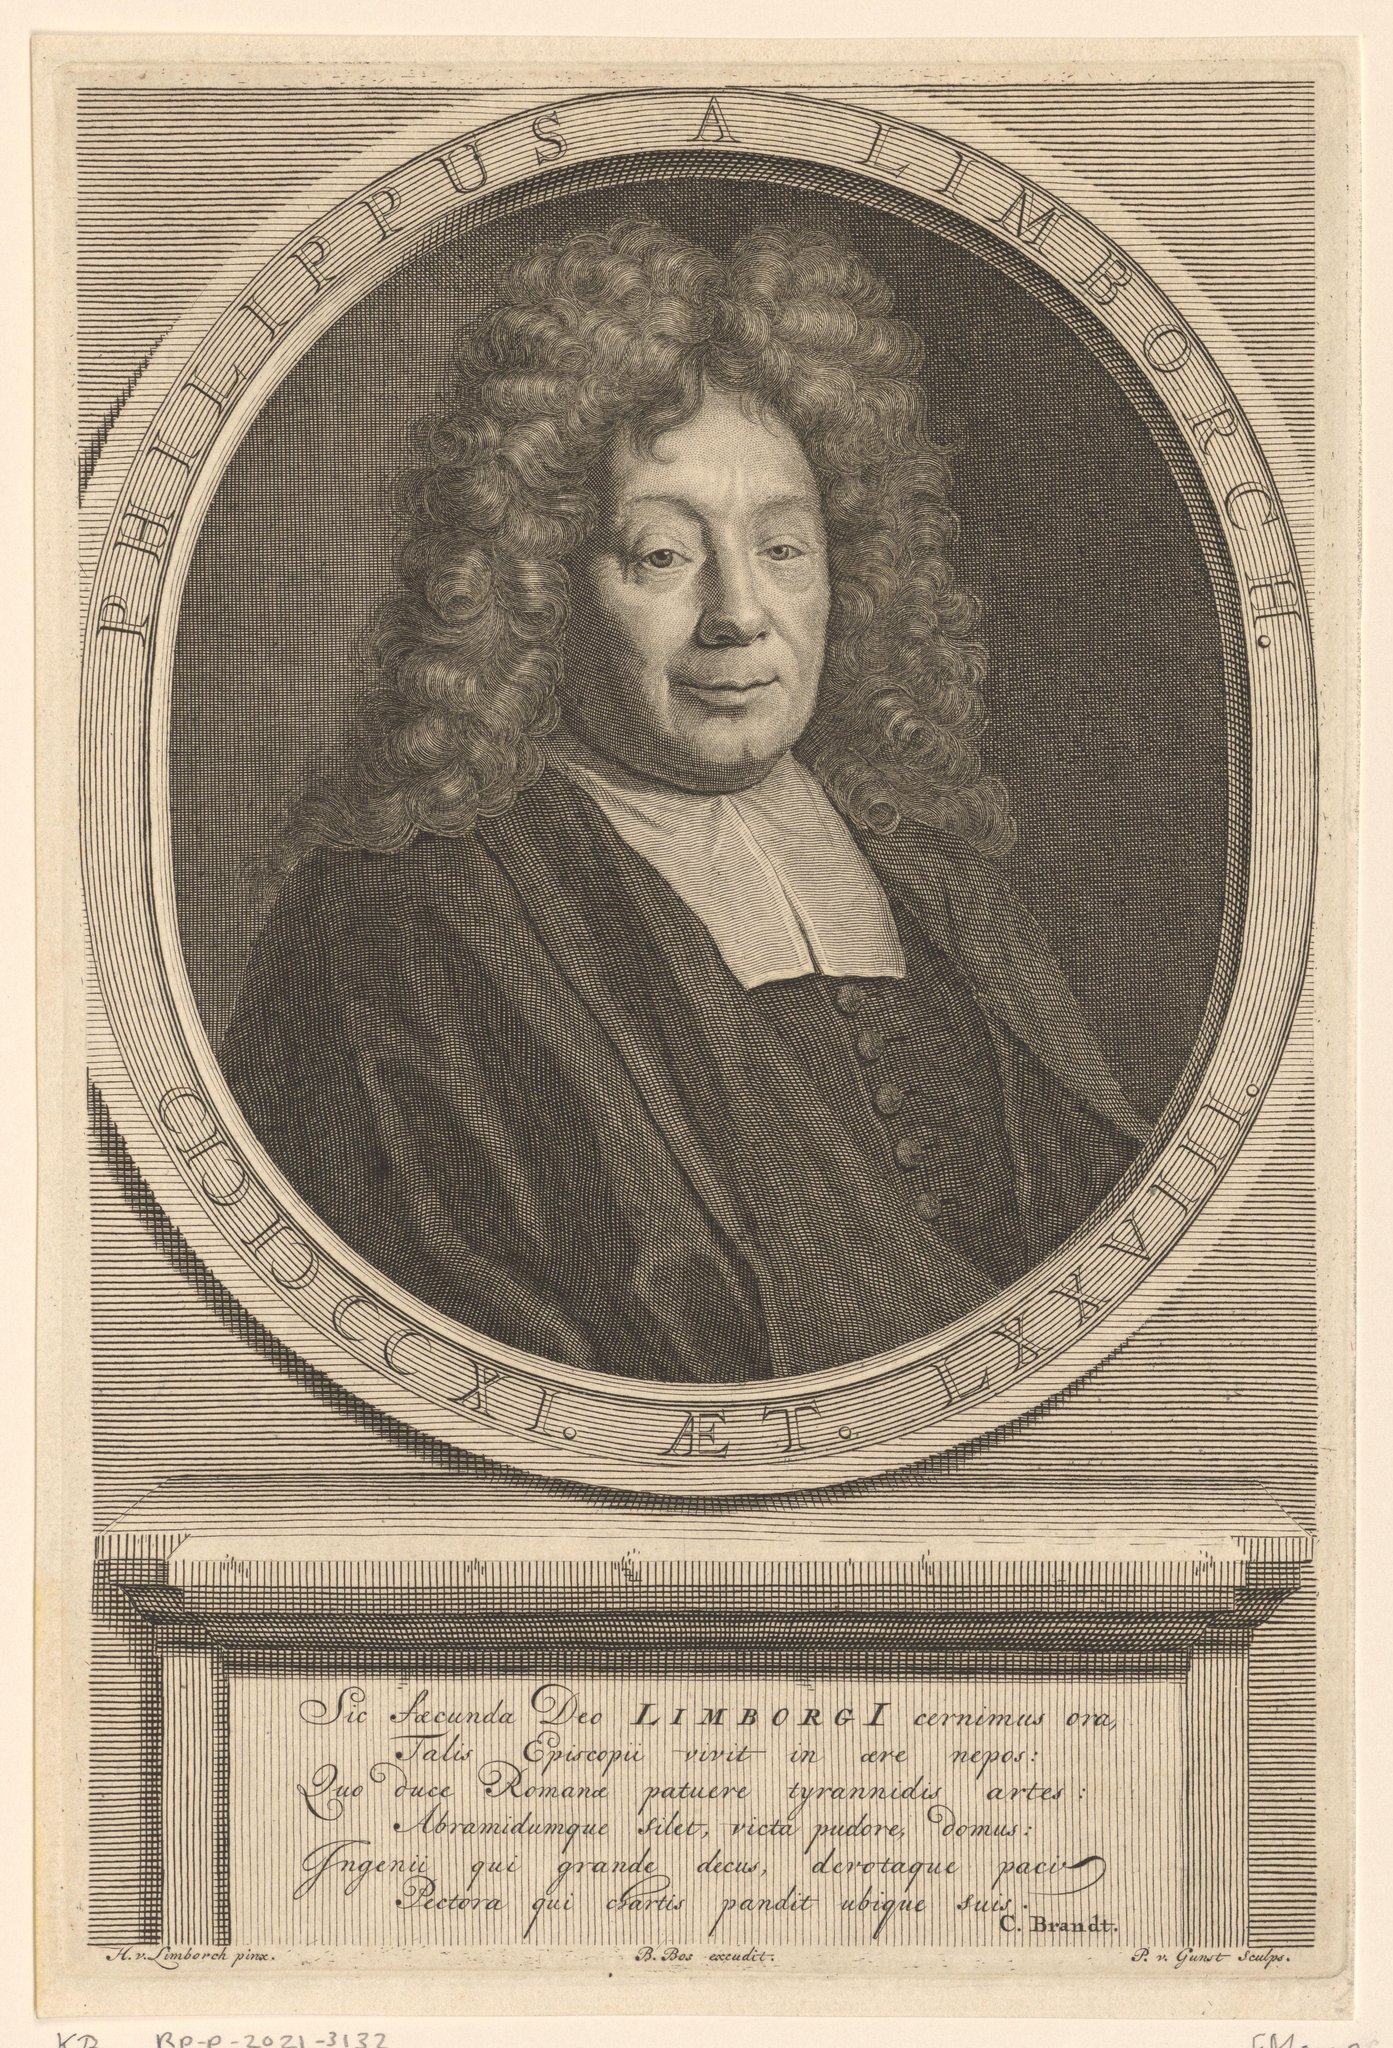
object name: print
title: Portret van Philippus van Limborch op 78-jarige leeftijd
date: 1711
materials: paper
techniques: engraving, etching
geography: amsterdam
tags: theologian, ornament ~ medallion, historical persons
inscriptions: collector's mark: Lugt 240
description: Prent waarschijnlijk uit: Limborch, Philippus van. Commentarius in Acta Apostolorum et in Epistolas Ad Romanos et ad Hebraeos. Rotterdam: Barent Bos, 1711. De prent is ook gebruikt in de Nederlandse vertaling van dit werk in 1713. Waarschijnlijk is in de vertaling het Nederlandse gedicht van Joan de Haes gebruikt, zie hiervoor RP-P-2021-3133.